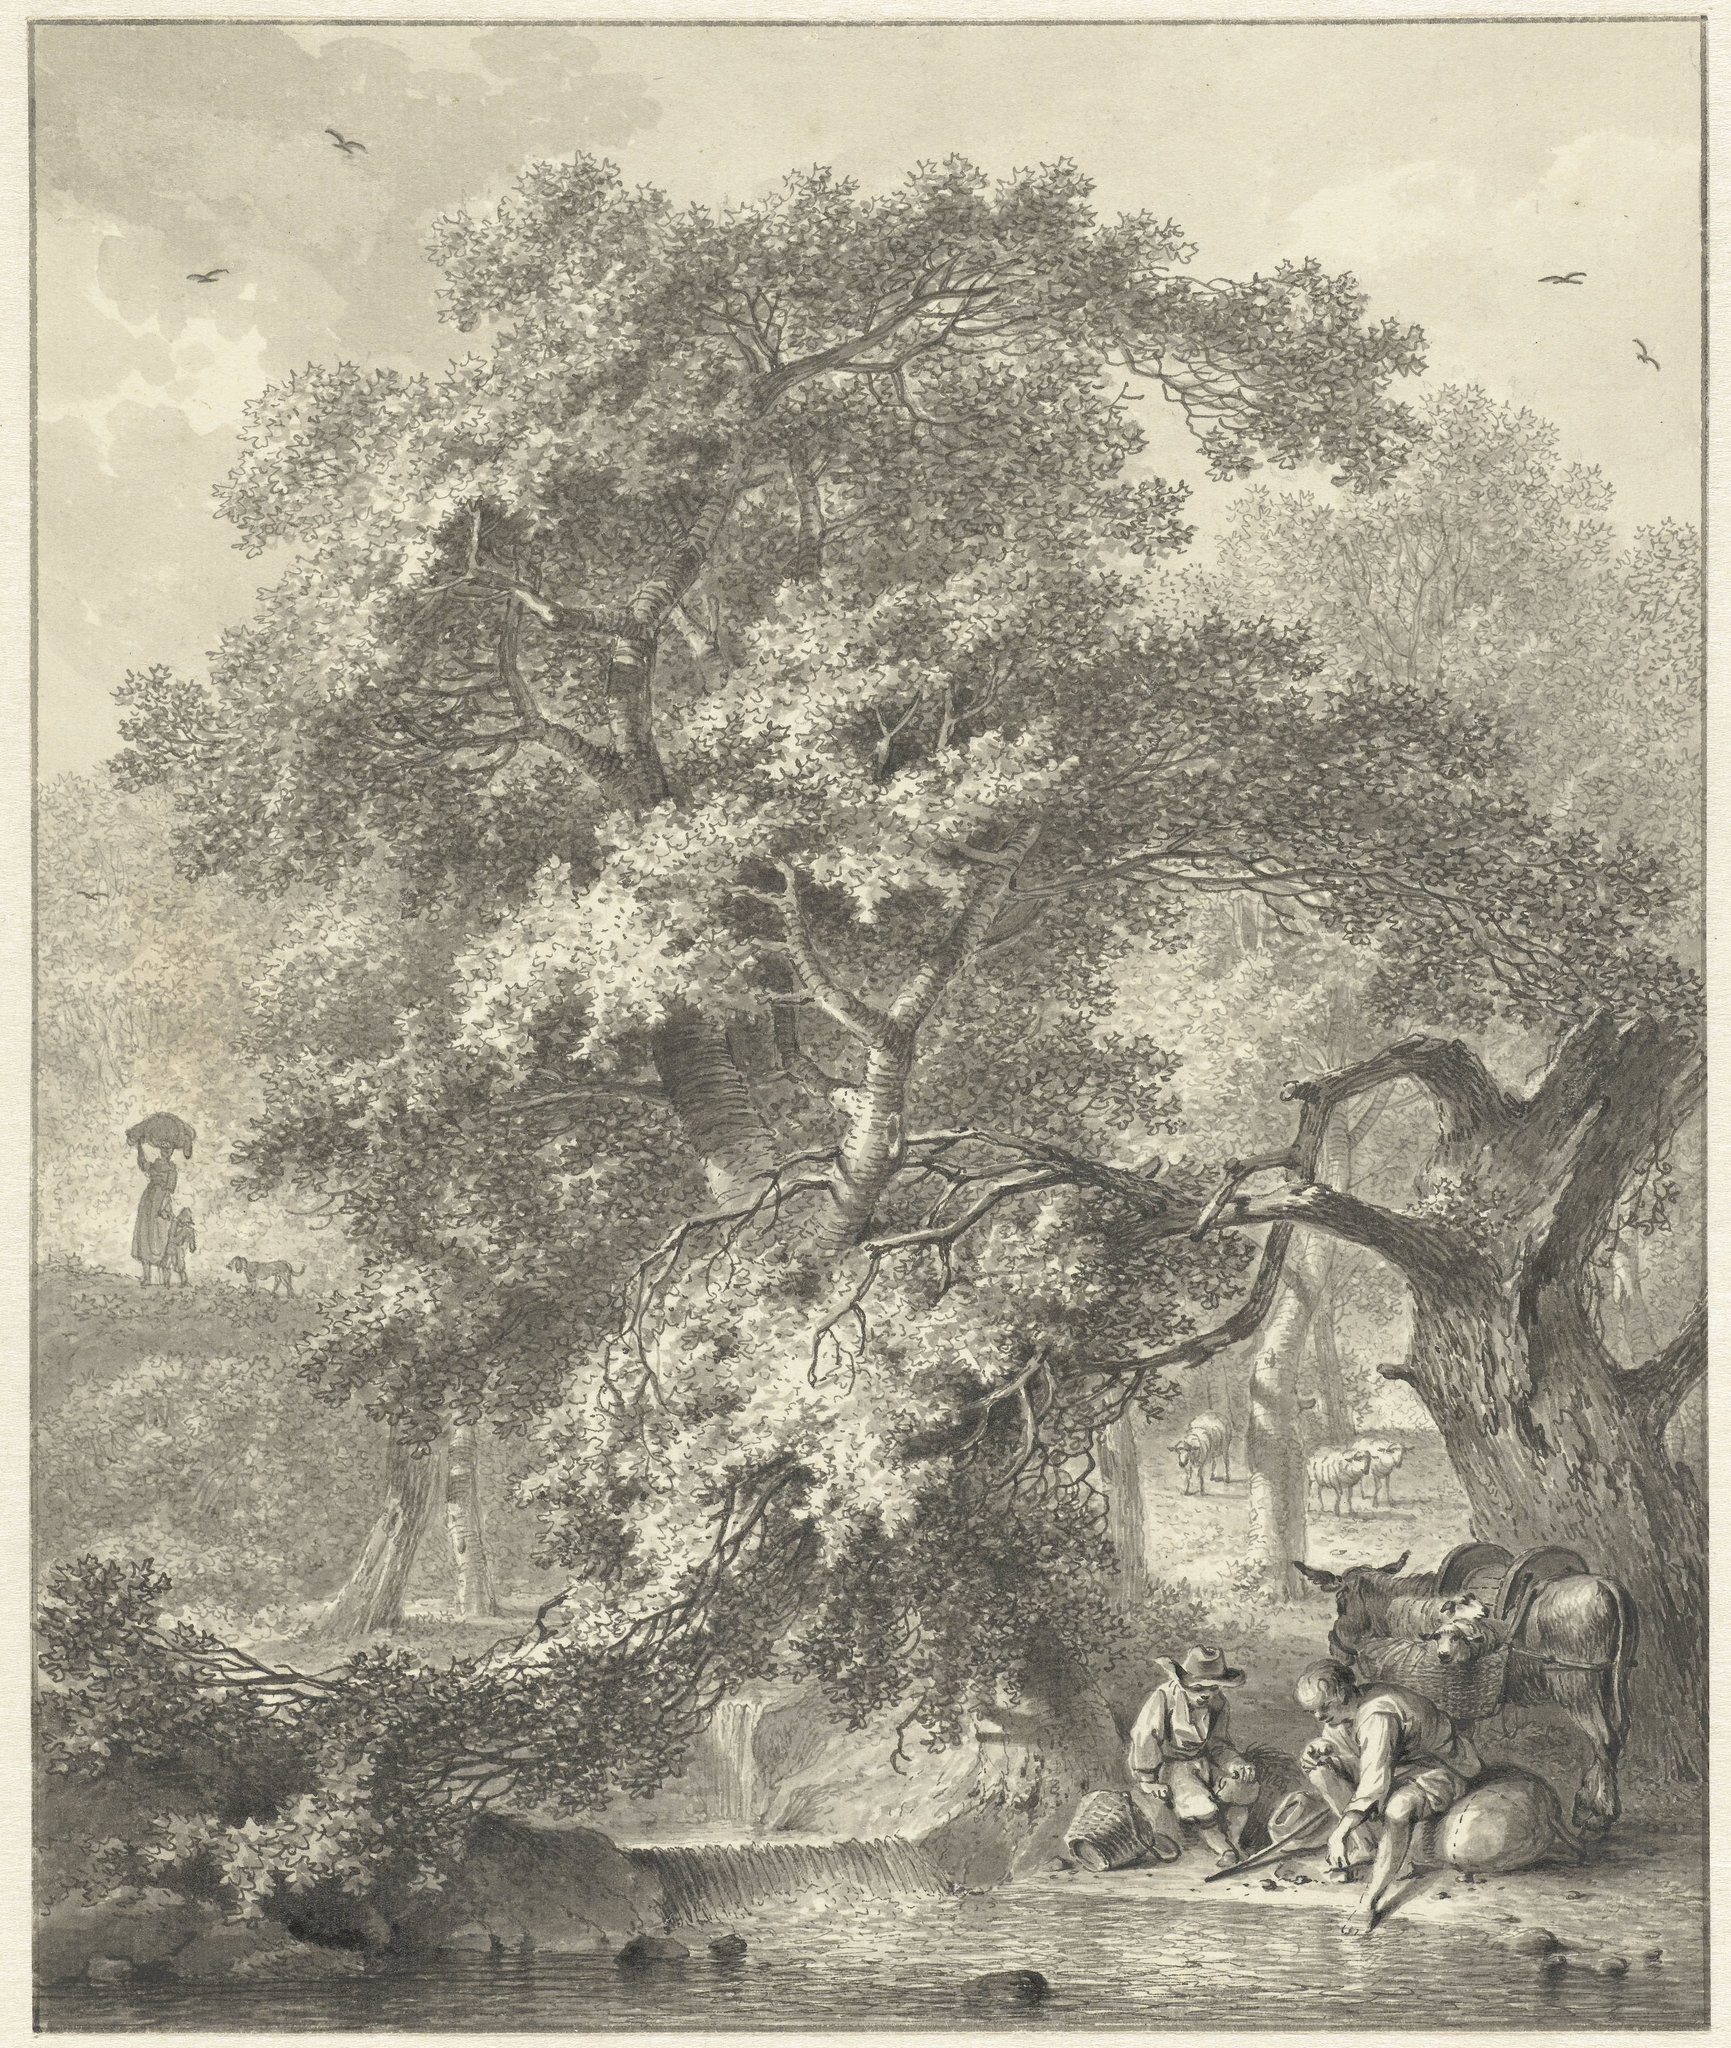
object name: drawing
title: Bosgezicht met rustende herders bij een watervalletje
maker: hendrik meijer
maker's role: draughtsman, print maker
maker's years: 1744-1793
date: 1783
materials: ink, paper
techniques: brush, pen